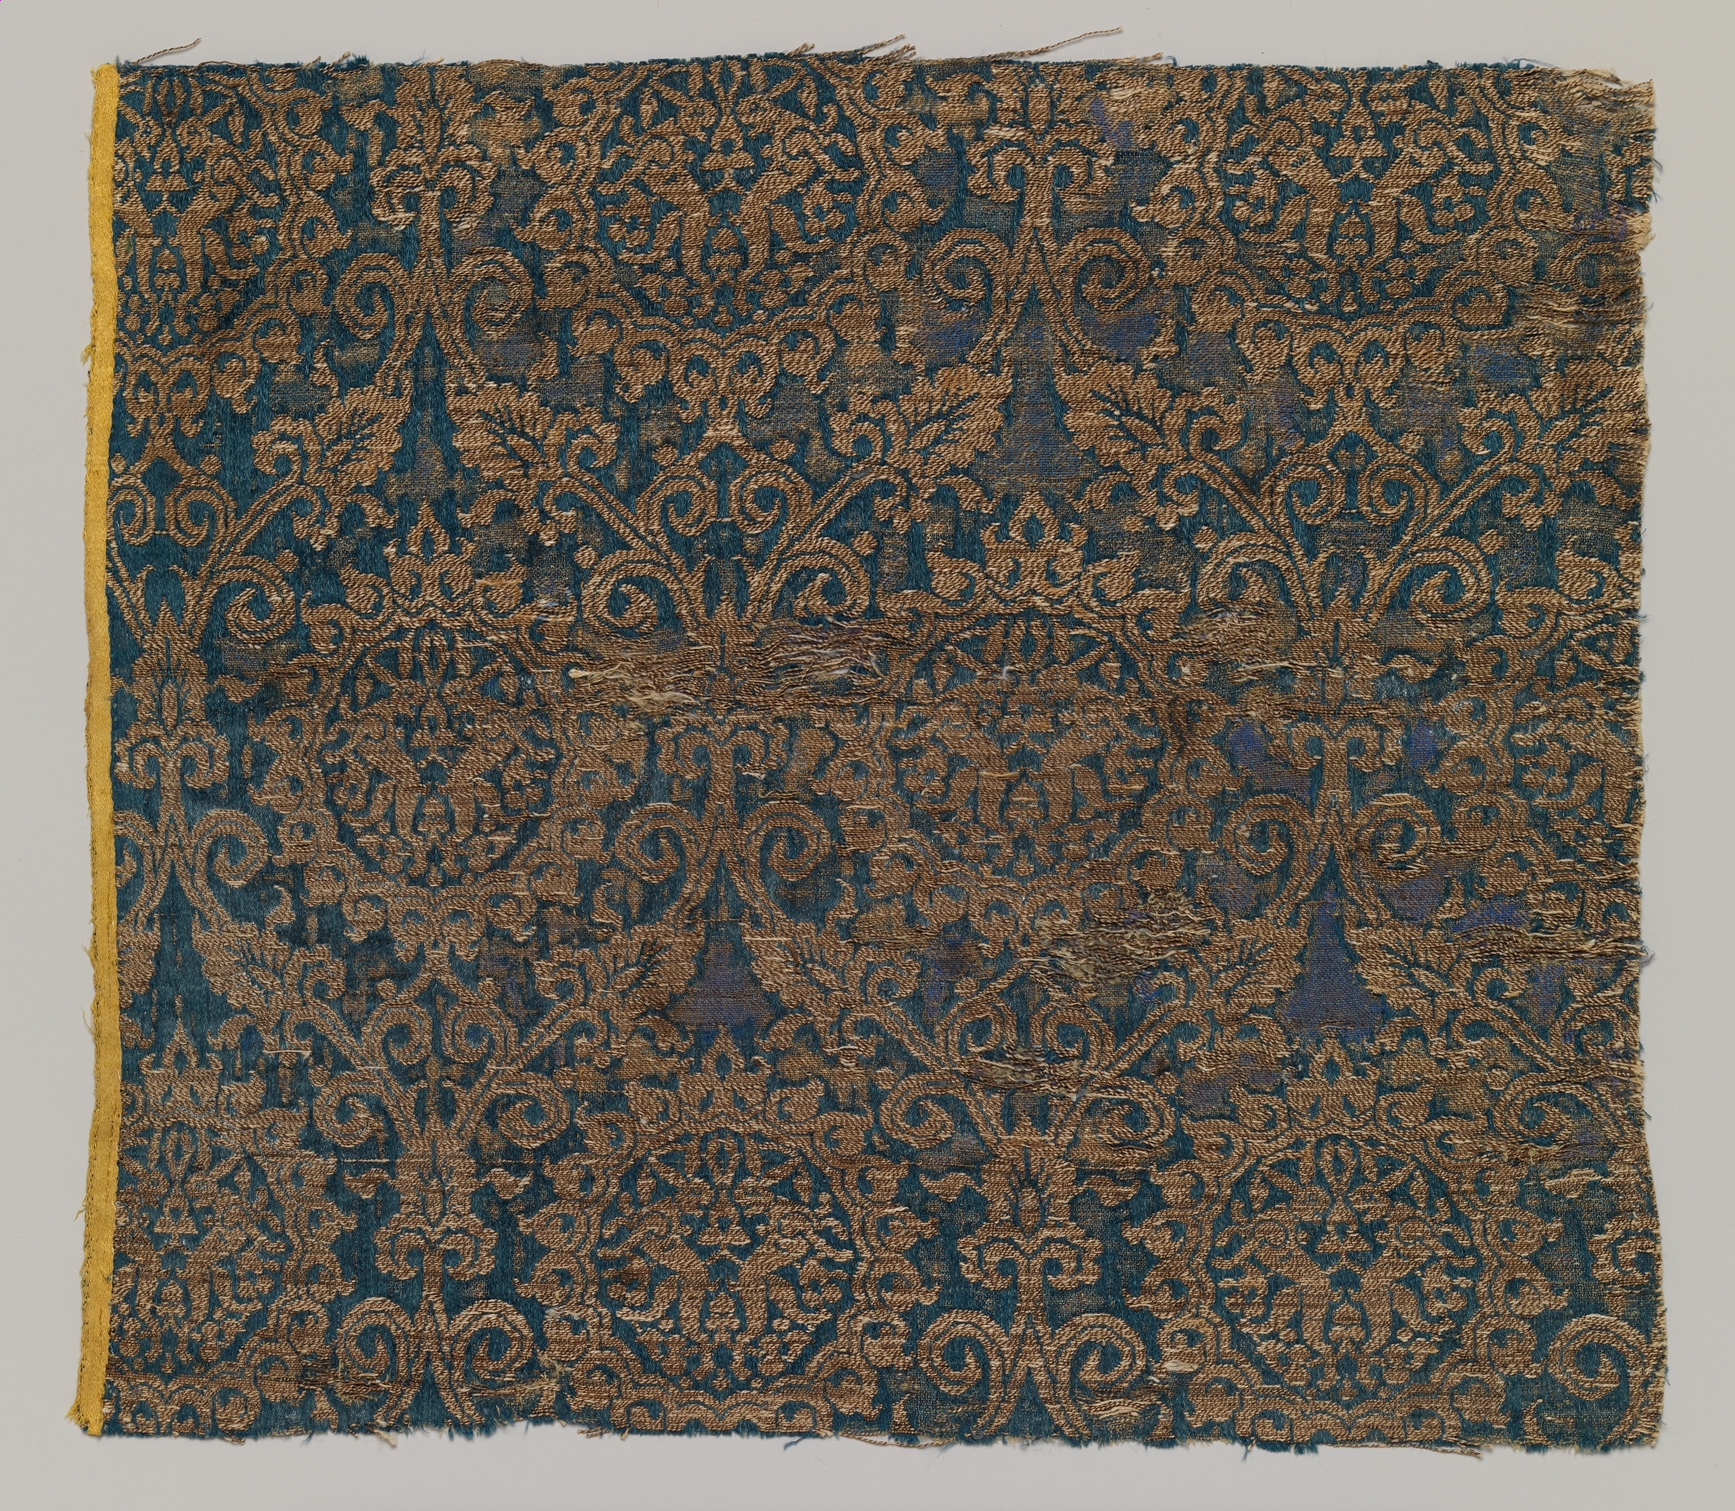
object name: textile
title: Textile with Brocade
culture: egyptian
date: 1301-1400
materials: metal thread, silk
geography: egypt